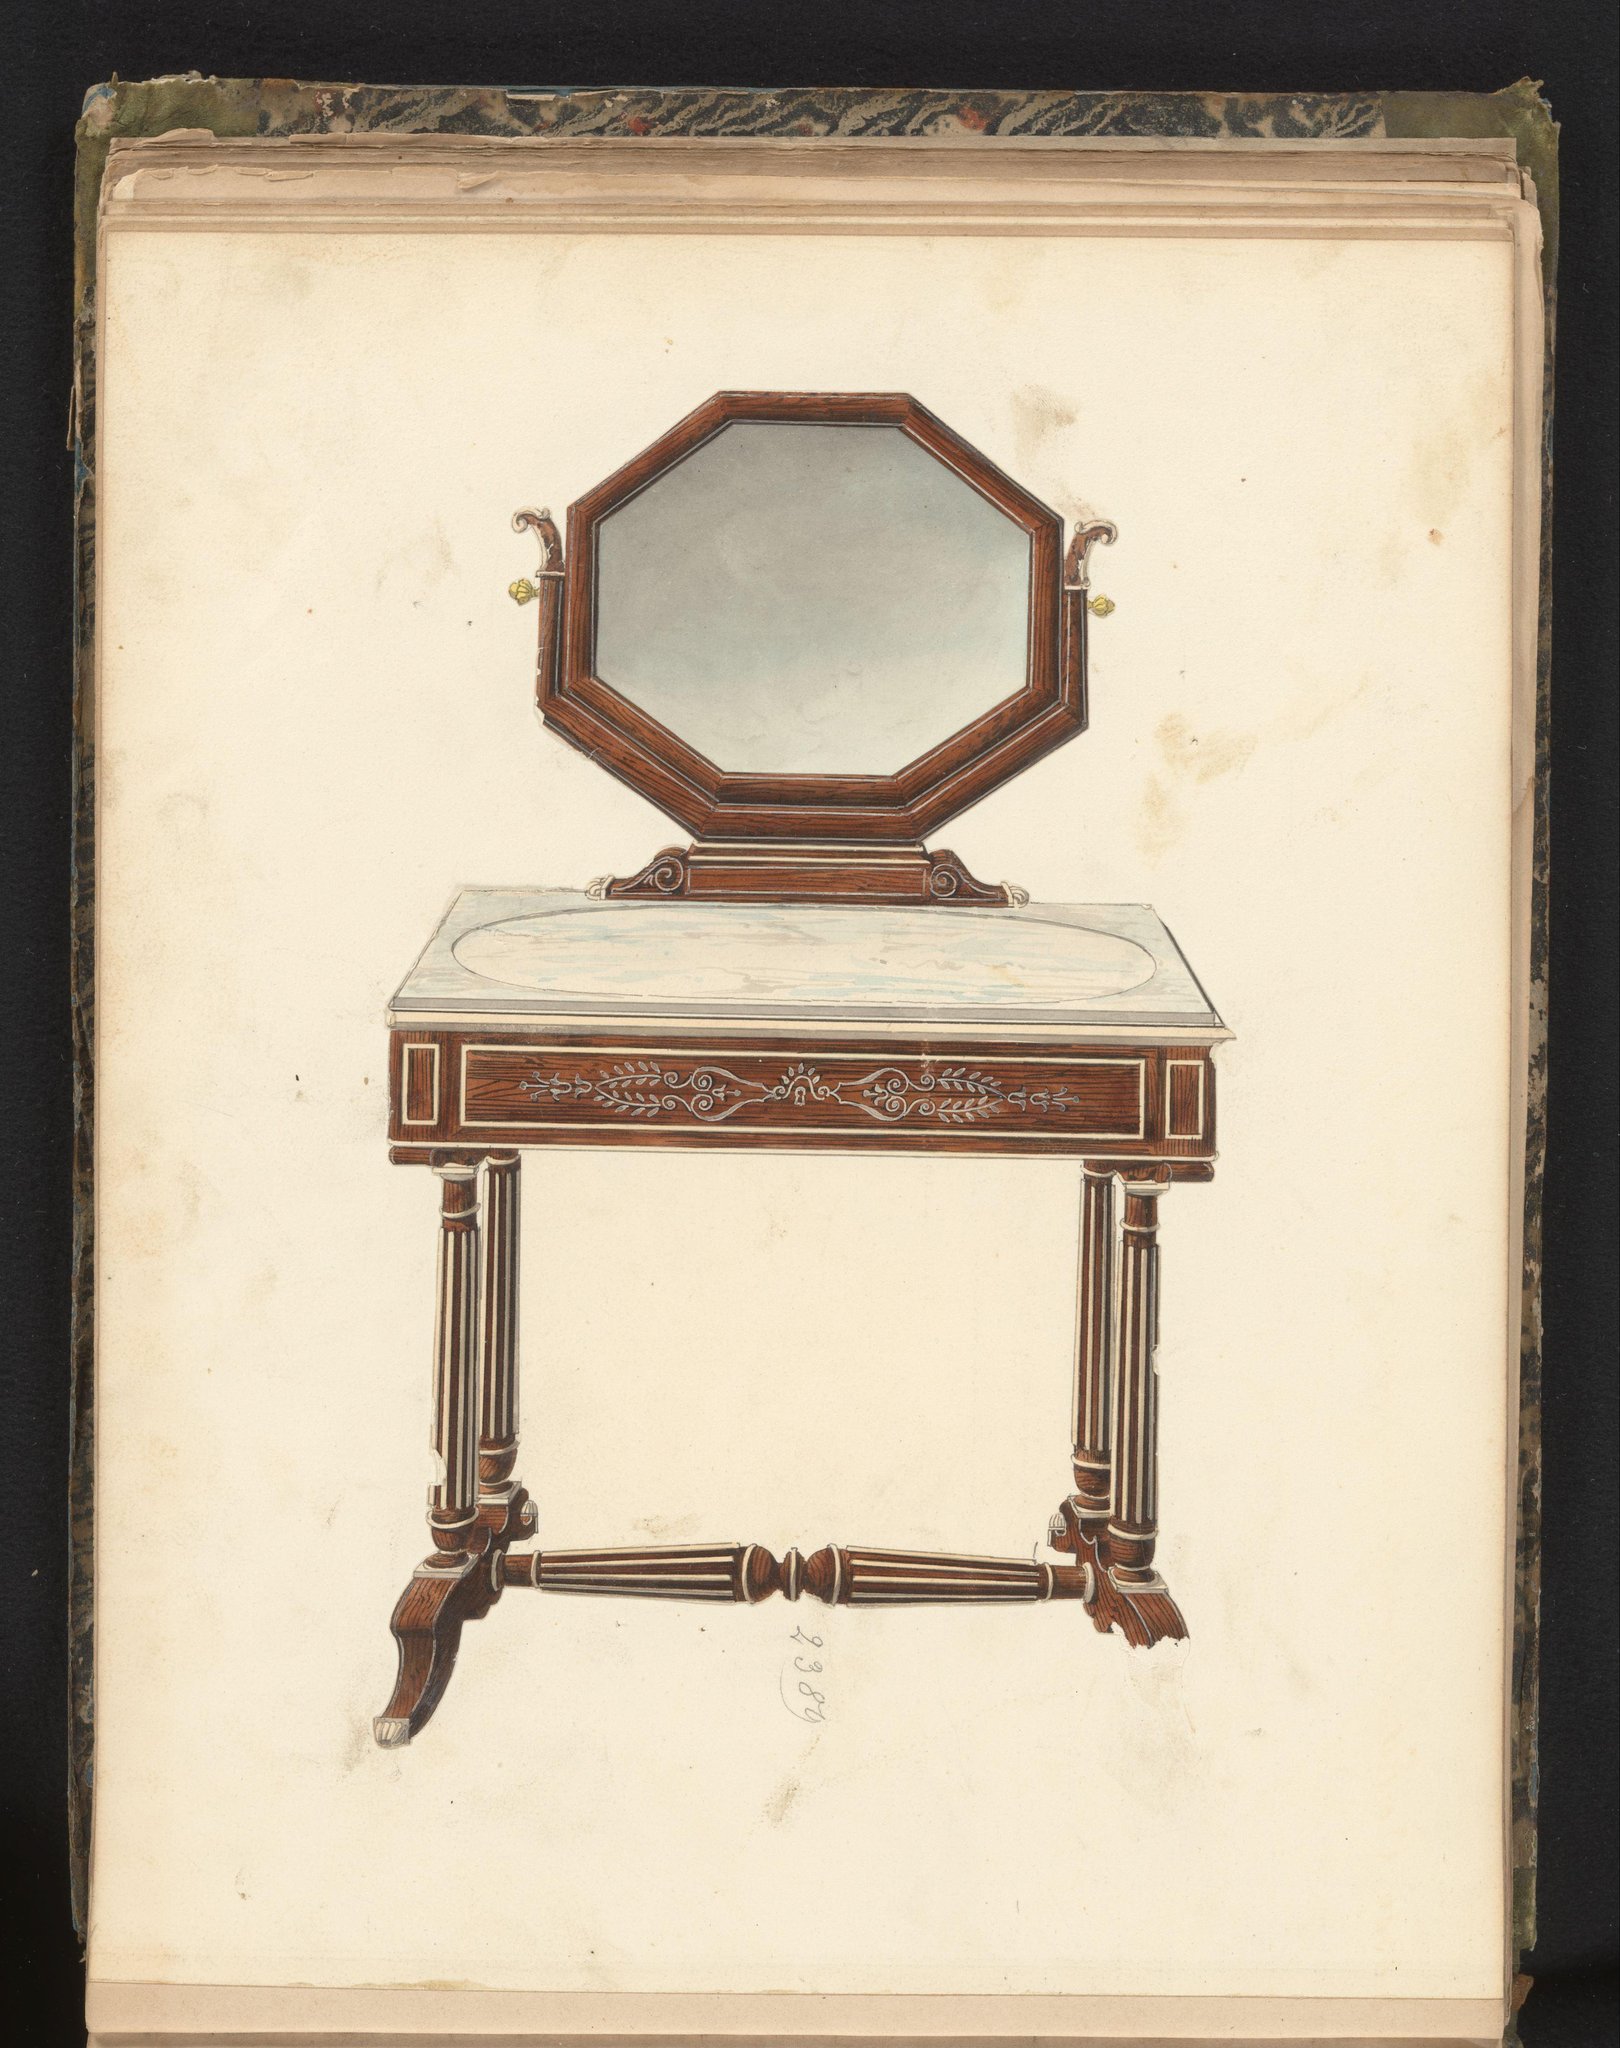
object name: drawing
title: Ontwerp voor toilettafel met achthoekige spiegel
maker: Anonymous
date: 1825-1839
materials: ink, paper, pencil, watercolor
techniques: brush, pen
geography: paris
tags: mirror, furniture for special use (+ wood and other phytogenic material), table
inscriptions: inscription: ‘2389 Toilette duchesse palissandre pied carreé sf patin’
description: Toilettafel met marmeren blad en een 8-hoekige spiegel in een lijst en palisanderhout met metalen(?) inlegwerk. Het blad op de achterzijde genummerd: 14, het tegenoverliggende blad met informatie over de afgebeelde meubelen genummerd: 14 bis. Onderdeel van een album met 80 bladen met tekeningen en een prent van gefineerde en gelakte meubelen, alsmede zitmeubelen.